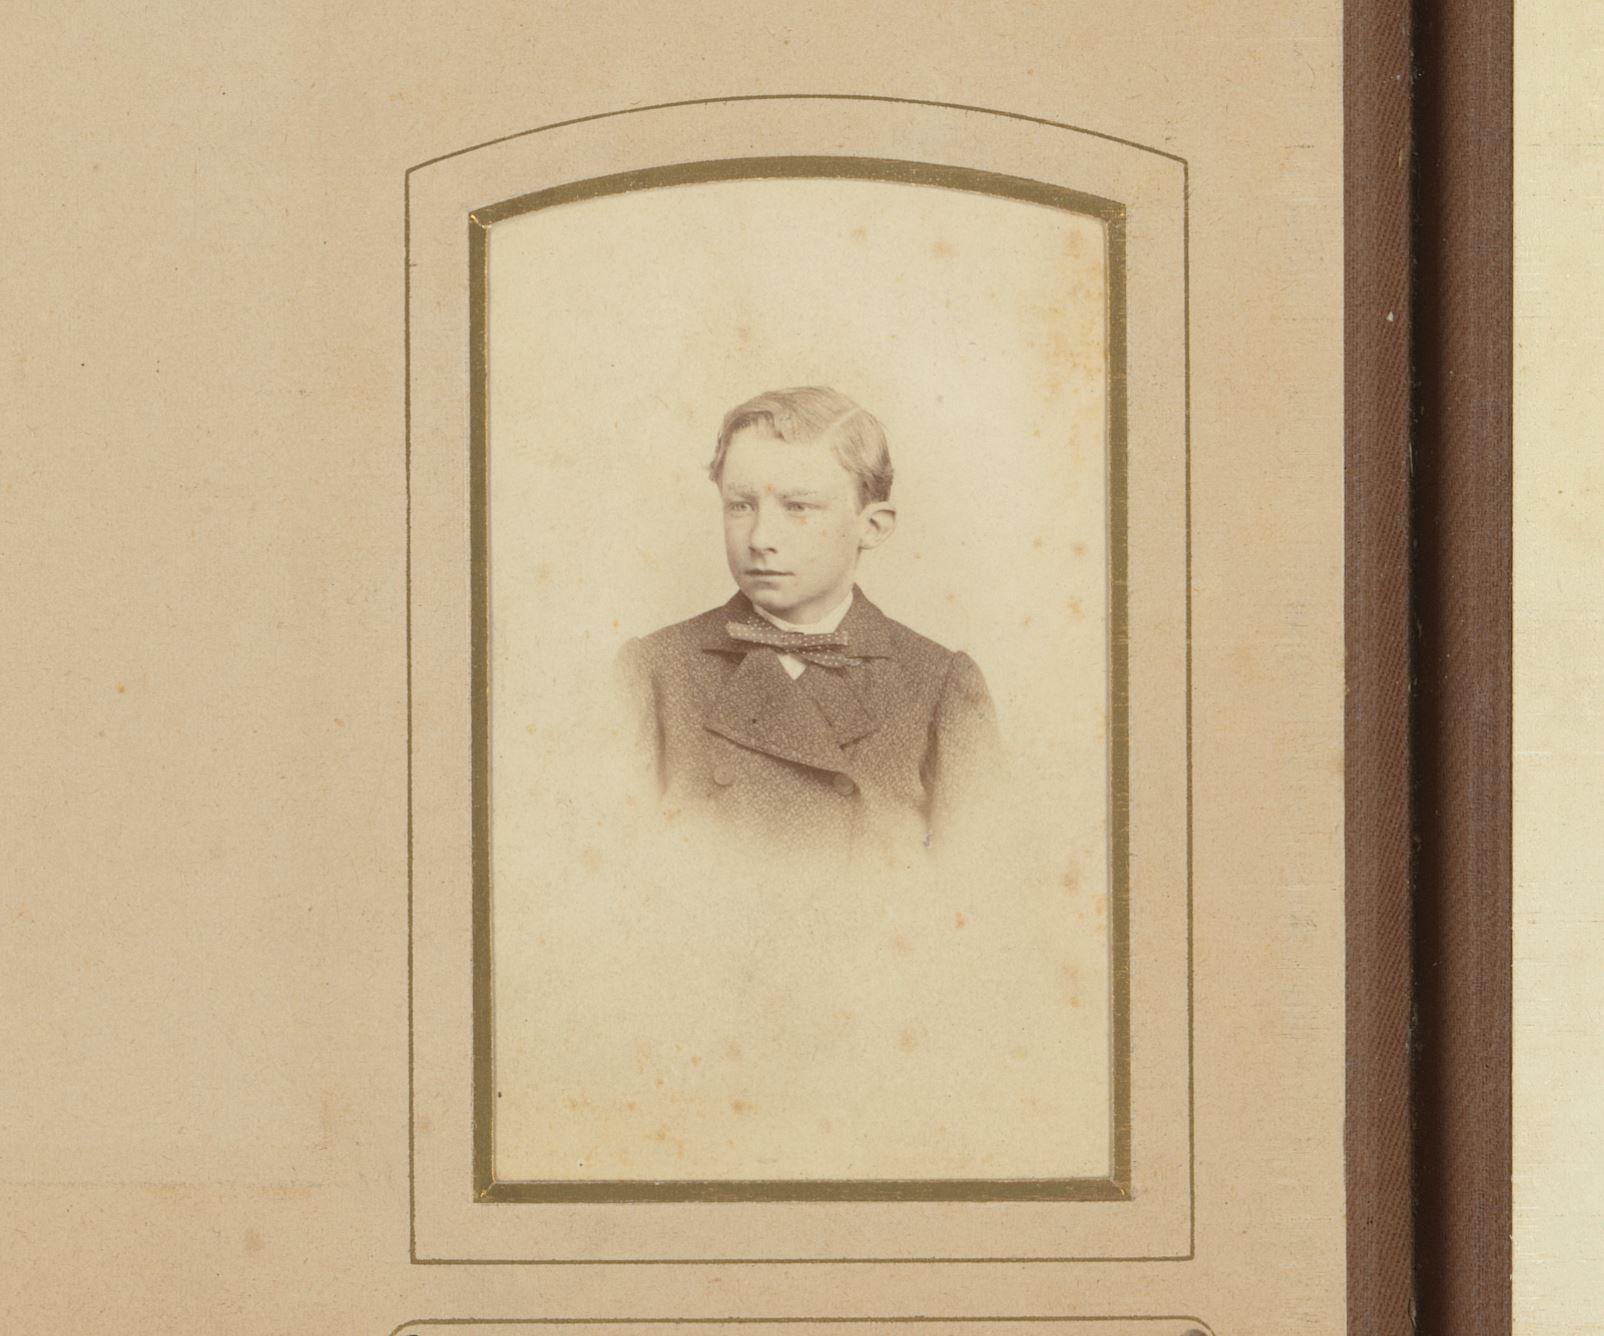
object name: carte de visite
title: Portret van een jongen met vlinderstrik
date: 1860-1894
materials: cardboard, photographic support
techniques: albumen print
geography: brussels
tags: boy (child between toddler and youth), historical persons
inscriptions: inscription: ‘GHÉMAR FRÈRES,/ PHOTOGRAPHES DU ROI,/ 27, rue de l'Ecuyer, 27/ Entrée par la porte cochère,/ BRUXELLES/ Les Clichés étant conservés indéfiniment/ on peut toujours se procurer de nouvelles/ épreueves de Cartes & Portraits sans reposer.’